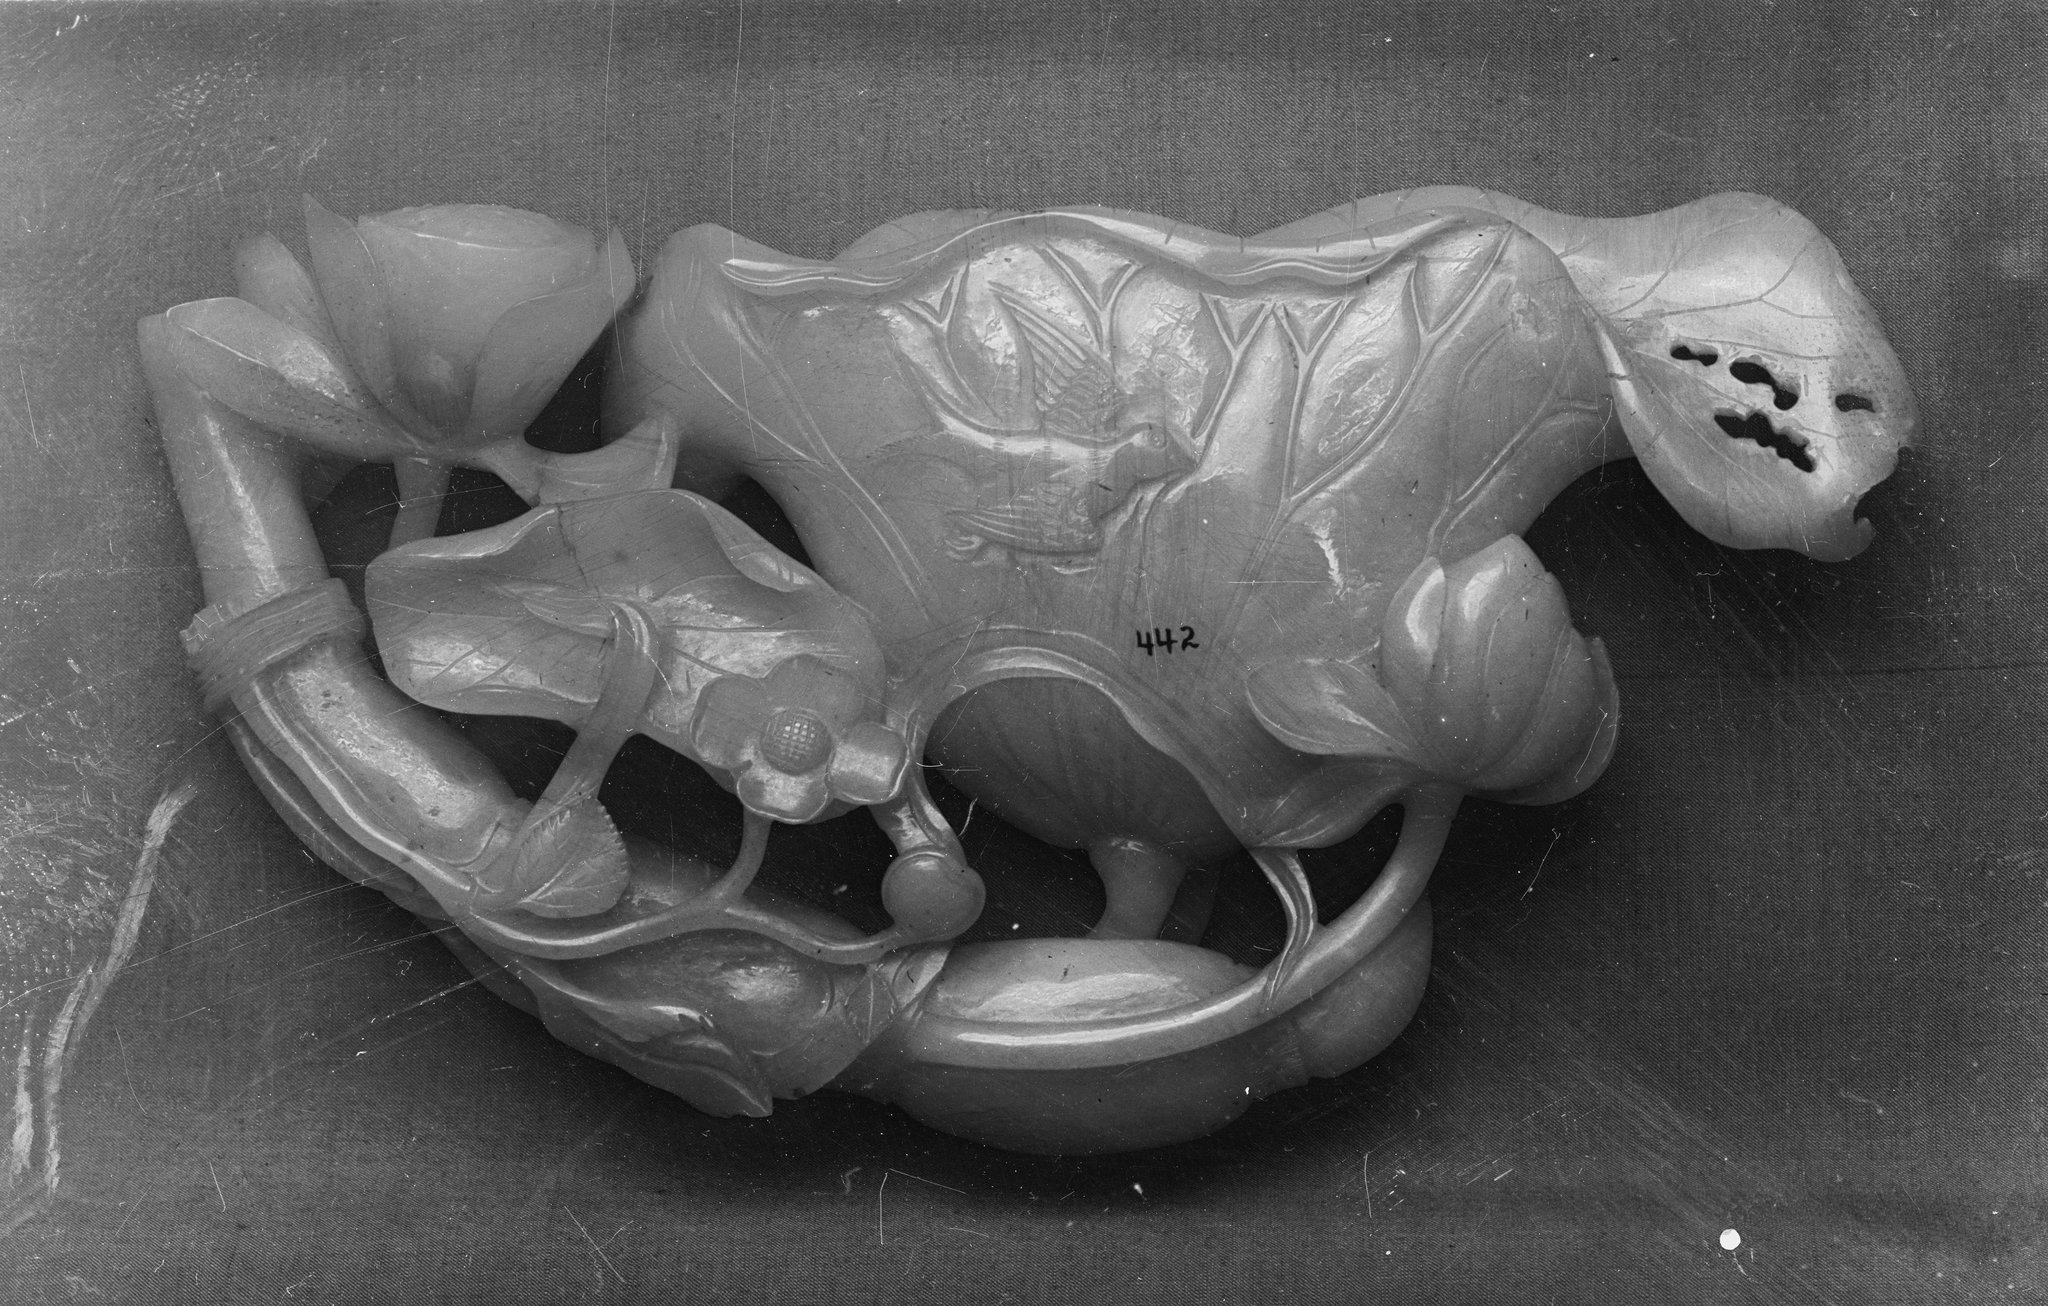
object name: flower vase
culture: chinese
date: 1662-1722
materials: jade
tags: flowers